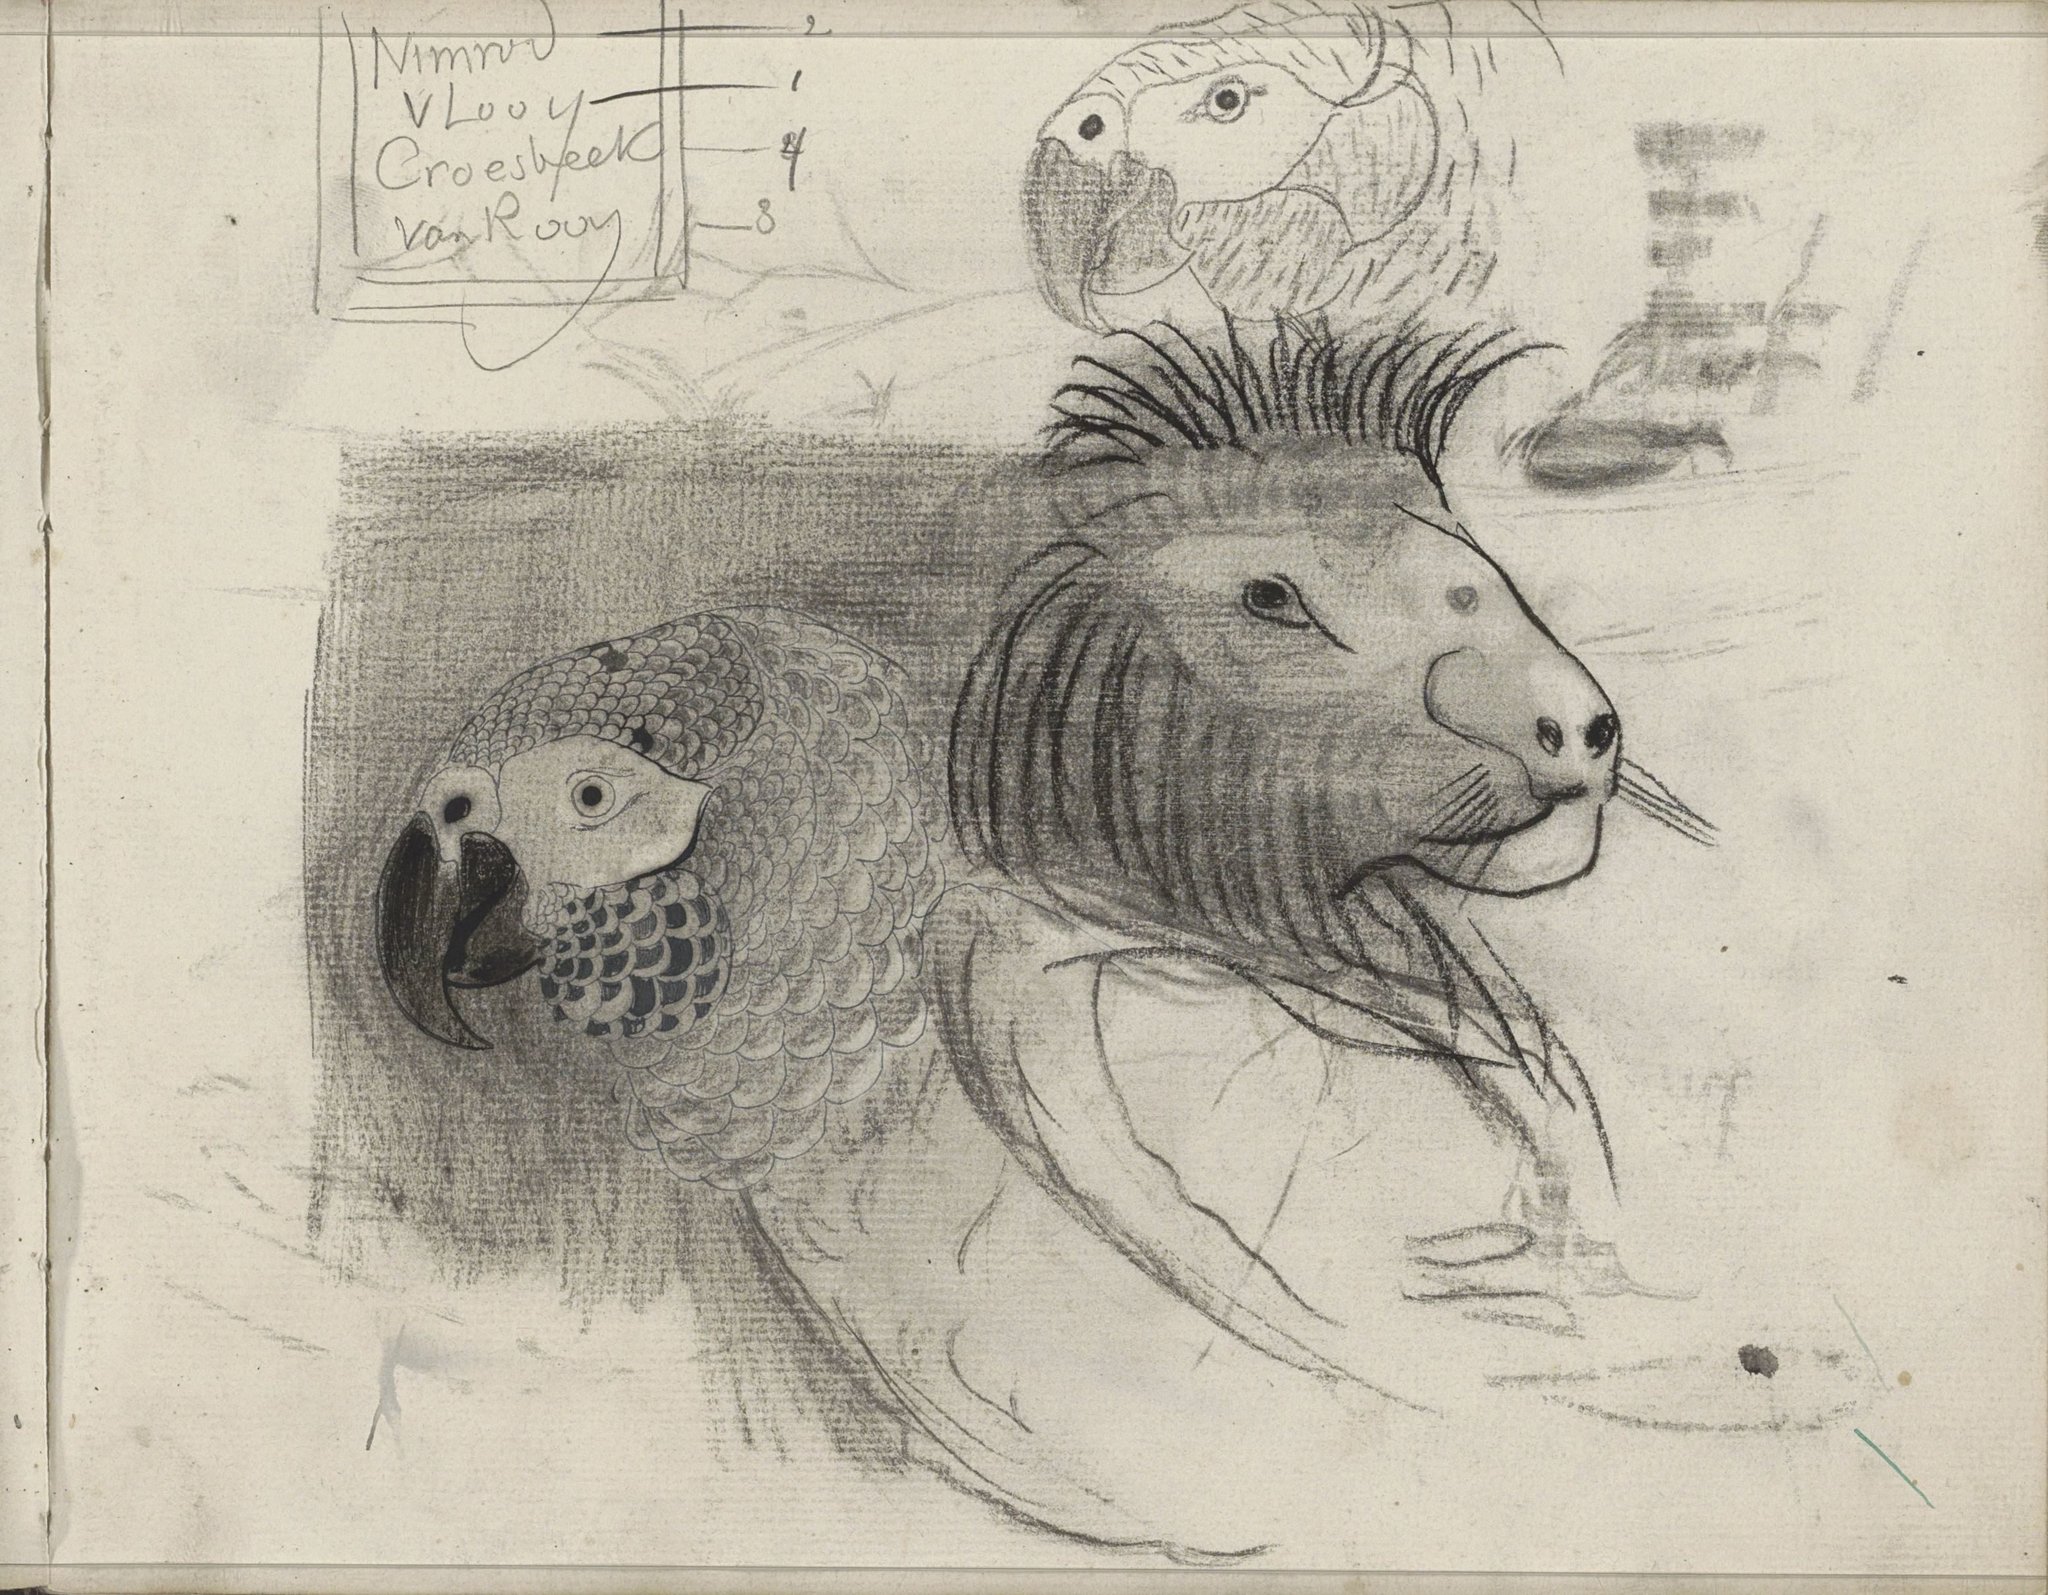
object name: sketchbook leaf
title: Koppen van een papegaai en een leeuw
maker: carel adolph lion cachet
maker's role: draughtsman, print maker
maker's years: 1864-1945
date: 1896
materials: chalk, paper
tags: ornamental birds: parrot, beasts of prey, predatory animals: lion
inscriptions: annotation: ‘Nimrod 2/ Vlooy 1/ Croesbeek 4/ van Rooy 3’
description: Blad 3 recto uit een schetsboek met 44 bladen.